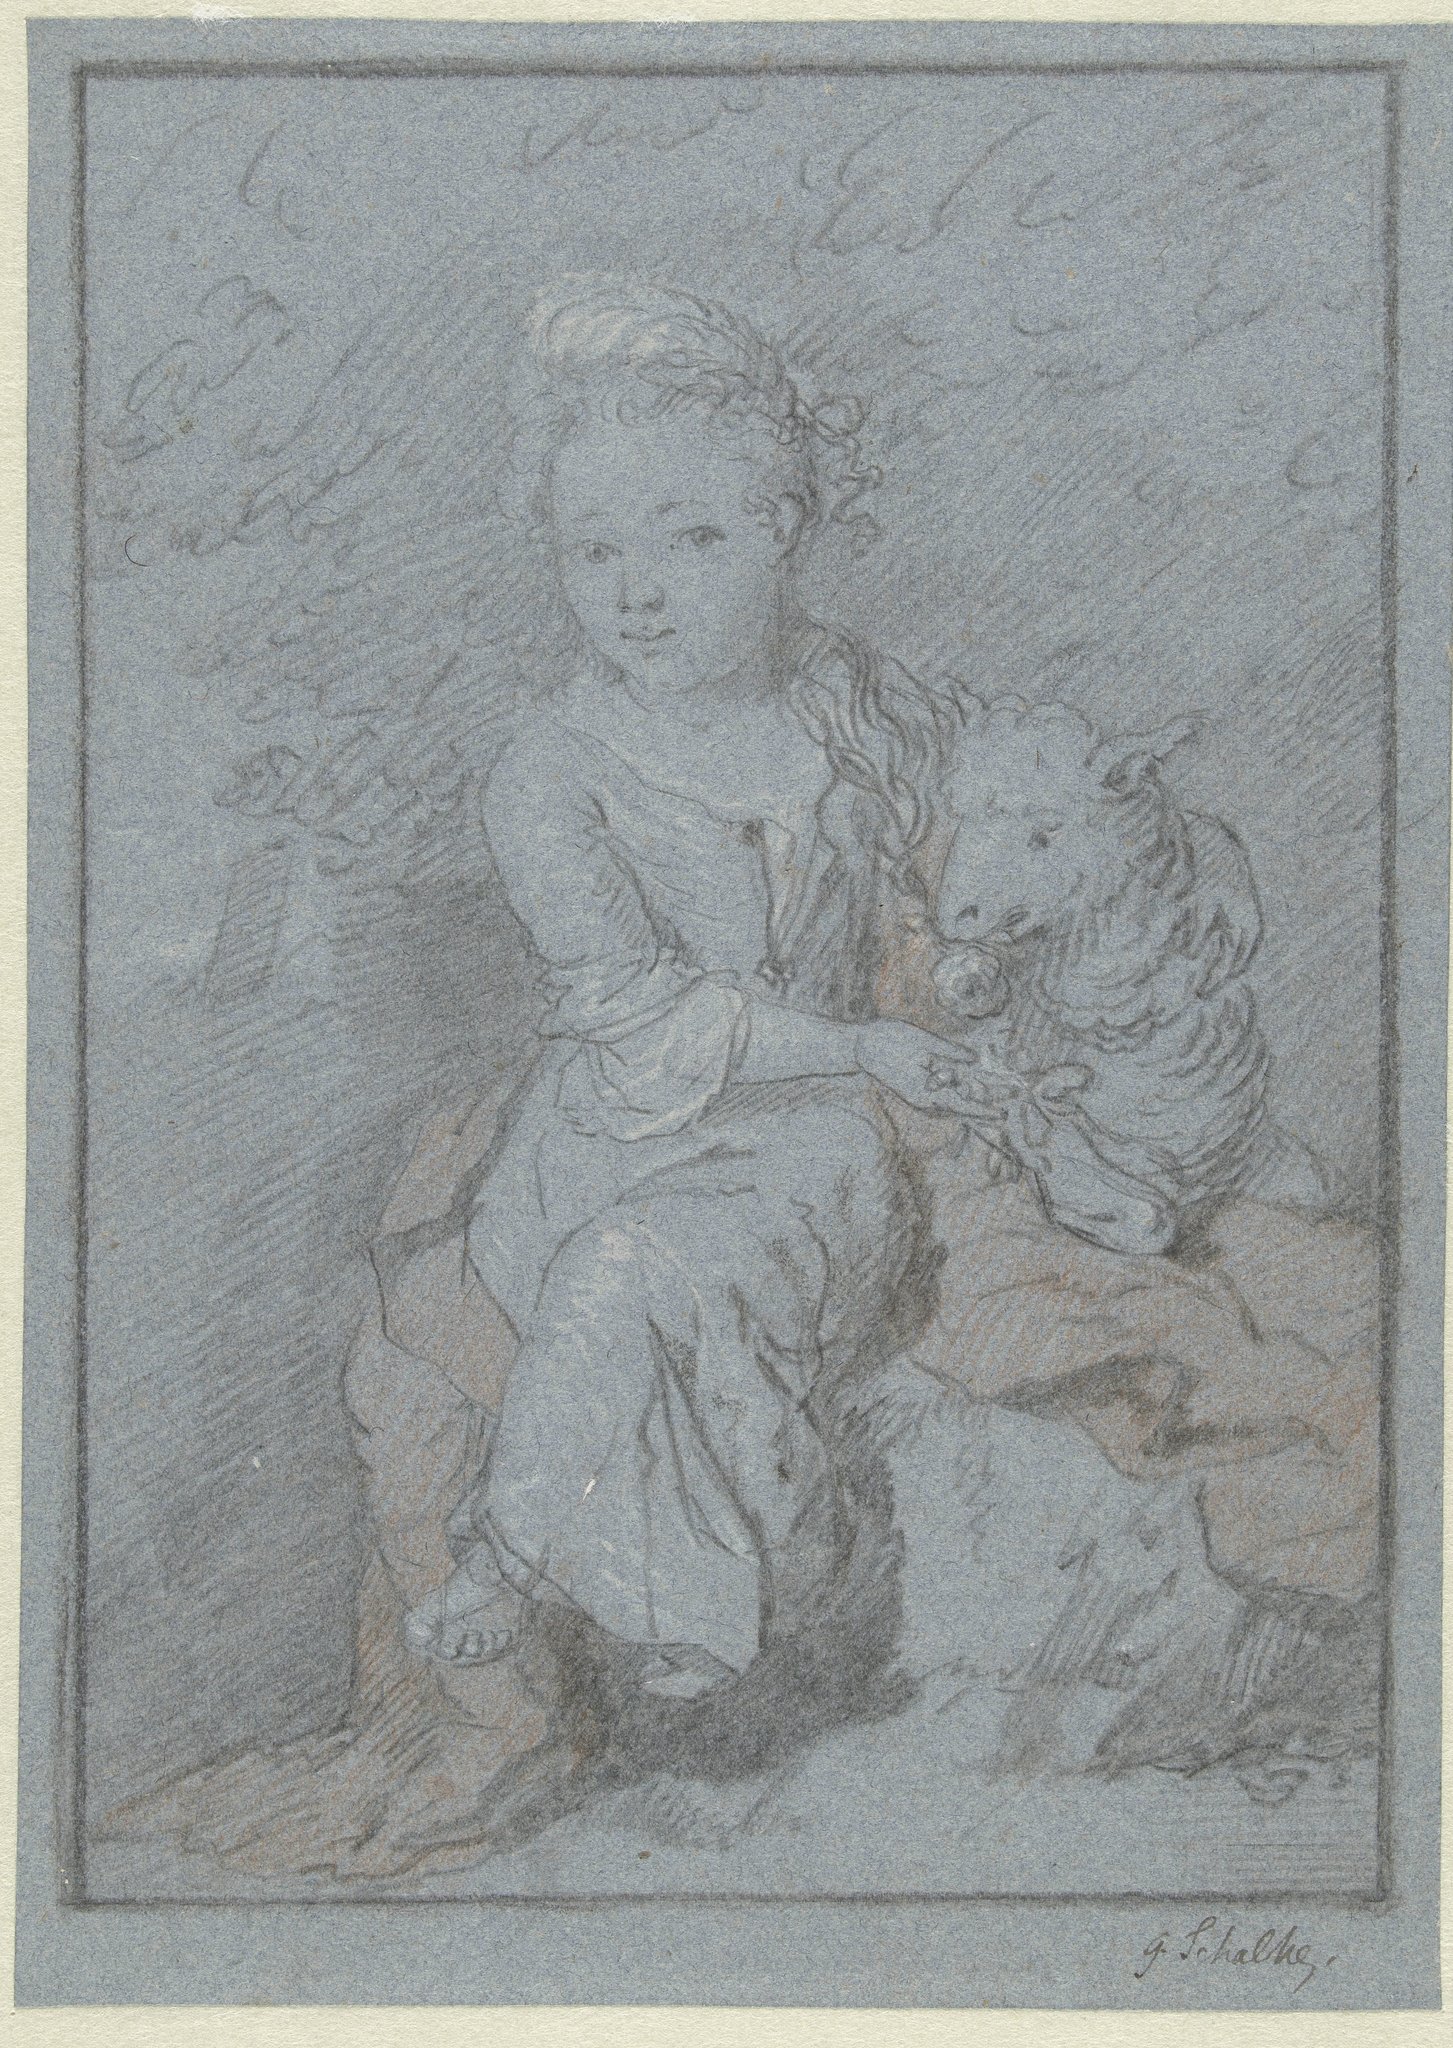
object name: drawing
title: Zittend meisje met een schaap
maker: godfried schalcken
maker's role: draughtsman, painter, print maker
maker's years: 1643-1706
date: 1653-1706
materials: chalk, paper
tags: sitting figure - aa - female human figure, girl (child between toddler and youth), sheep